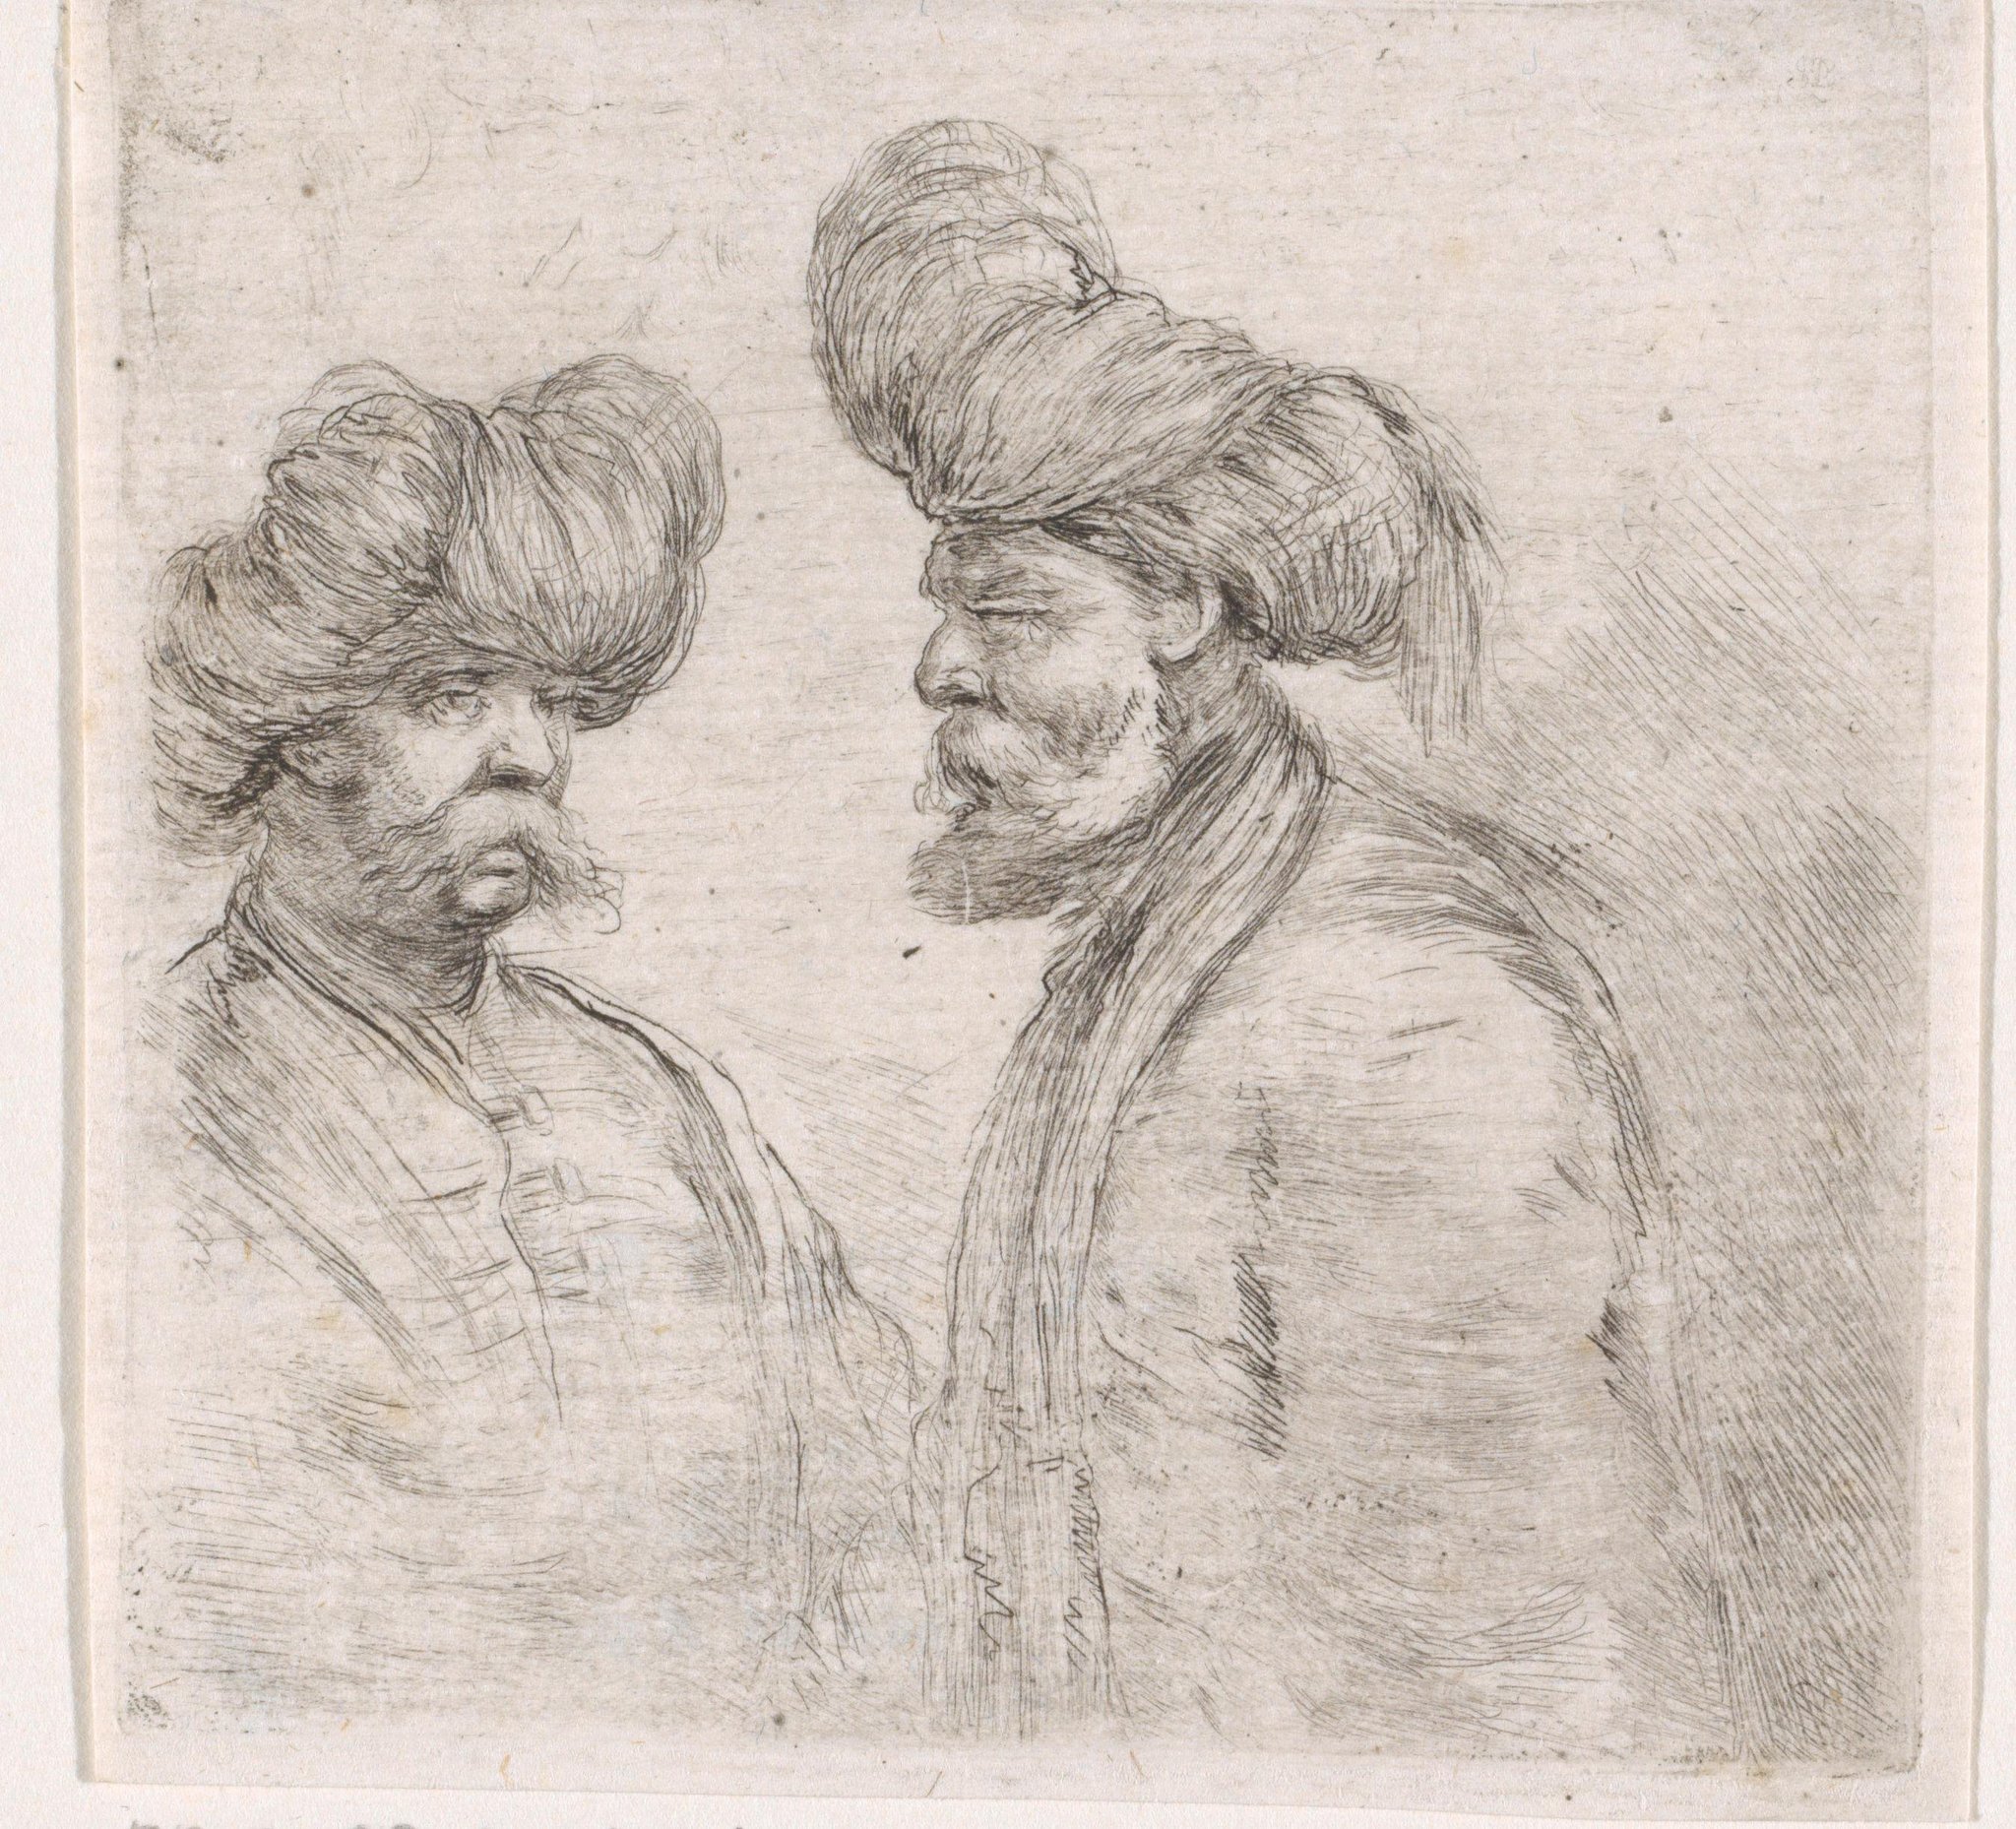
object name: print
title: Twee Turkse mannen met snorren en tulbanden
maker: stefano della bella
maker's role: draughtsman, print maker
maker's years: 1610-1664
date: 1620-1664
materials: paper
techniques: etching, intaglio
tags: asiatic races and peoples: turks, moustache, head-gear: turban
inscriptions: collector's mark: Lugt 240